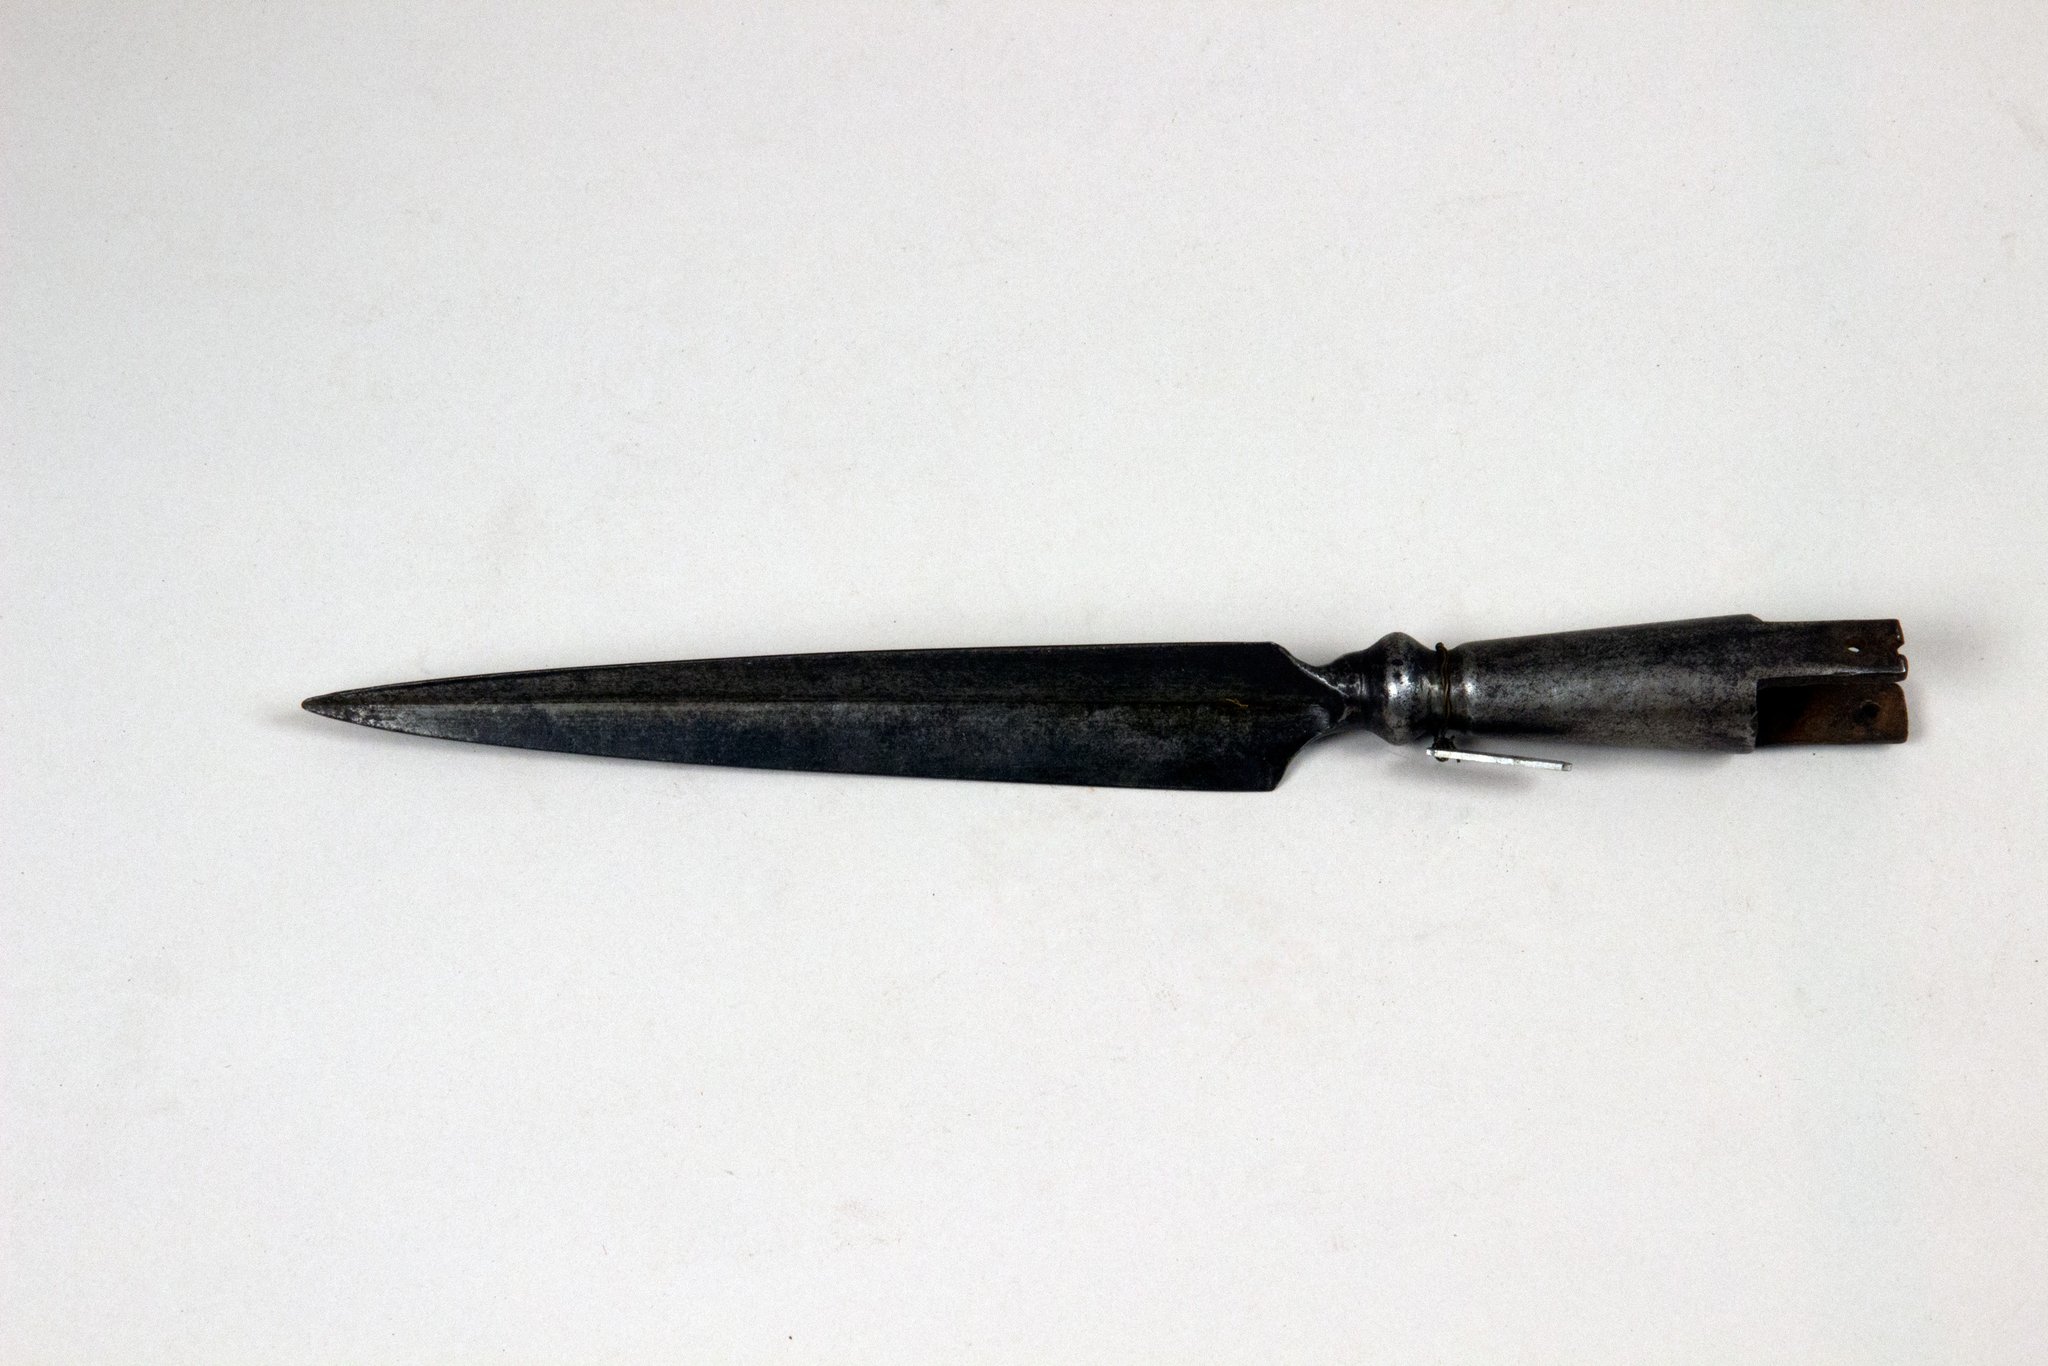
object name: spearhead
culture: turkish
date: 1701-1900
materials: steel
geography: ottoman empire